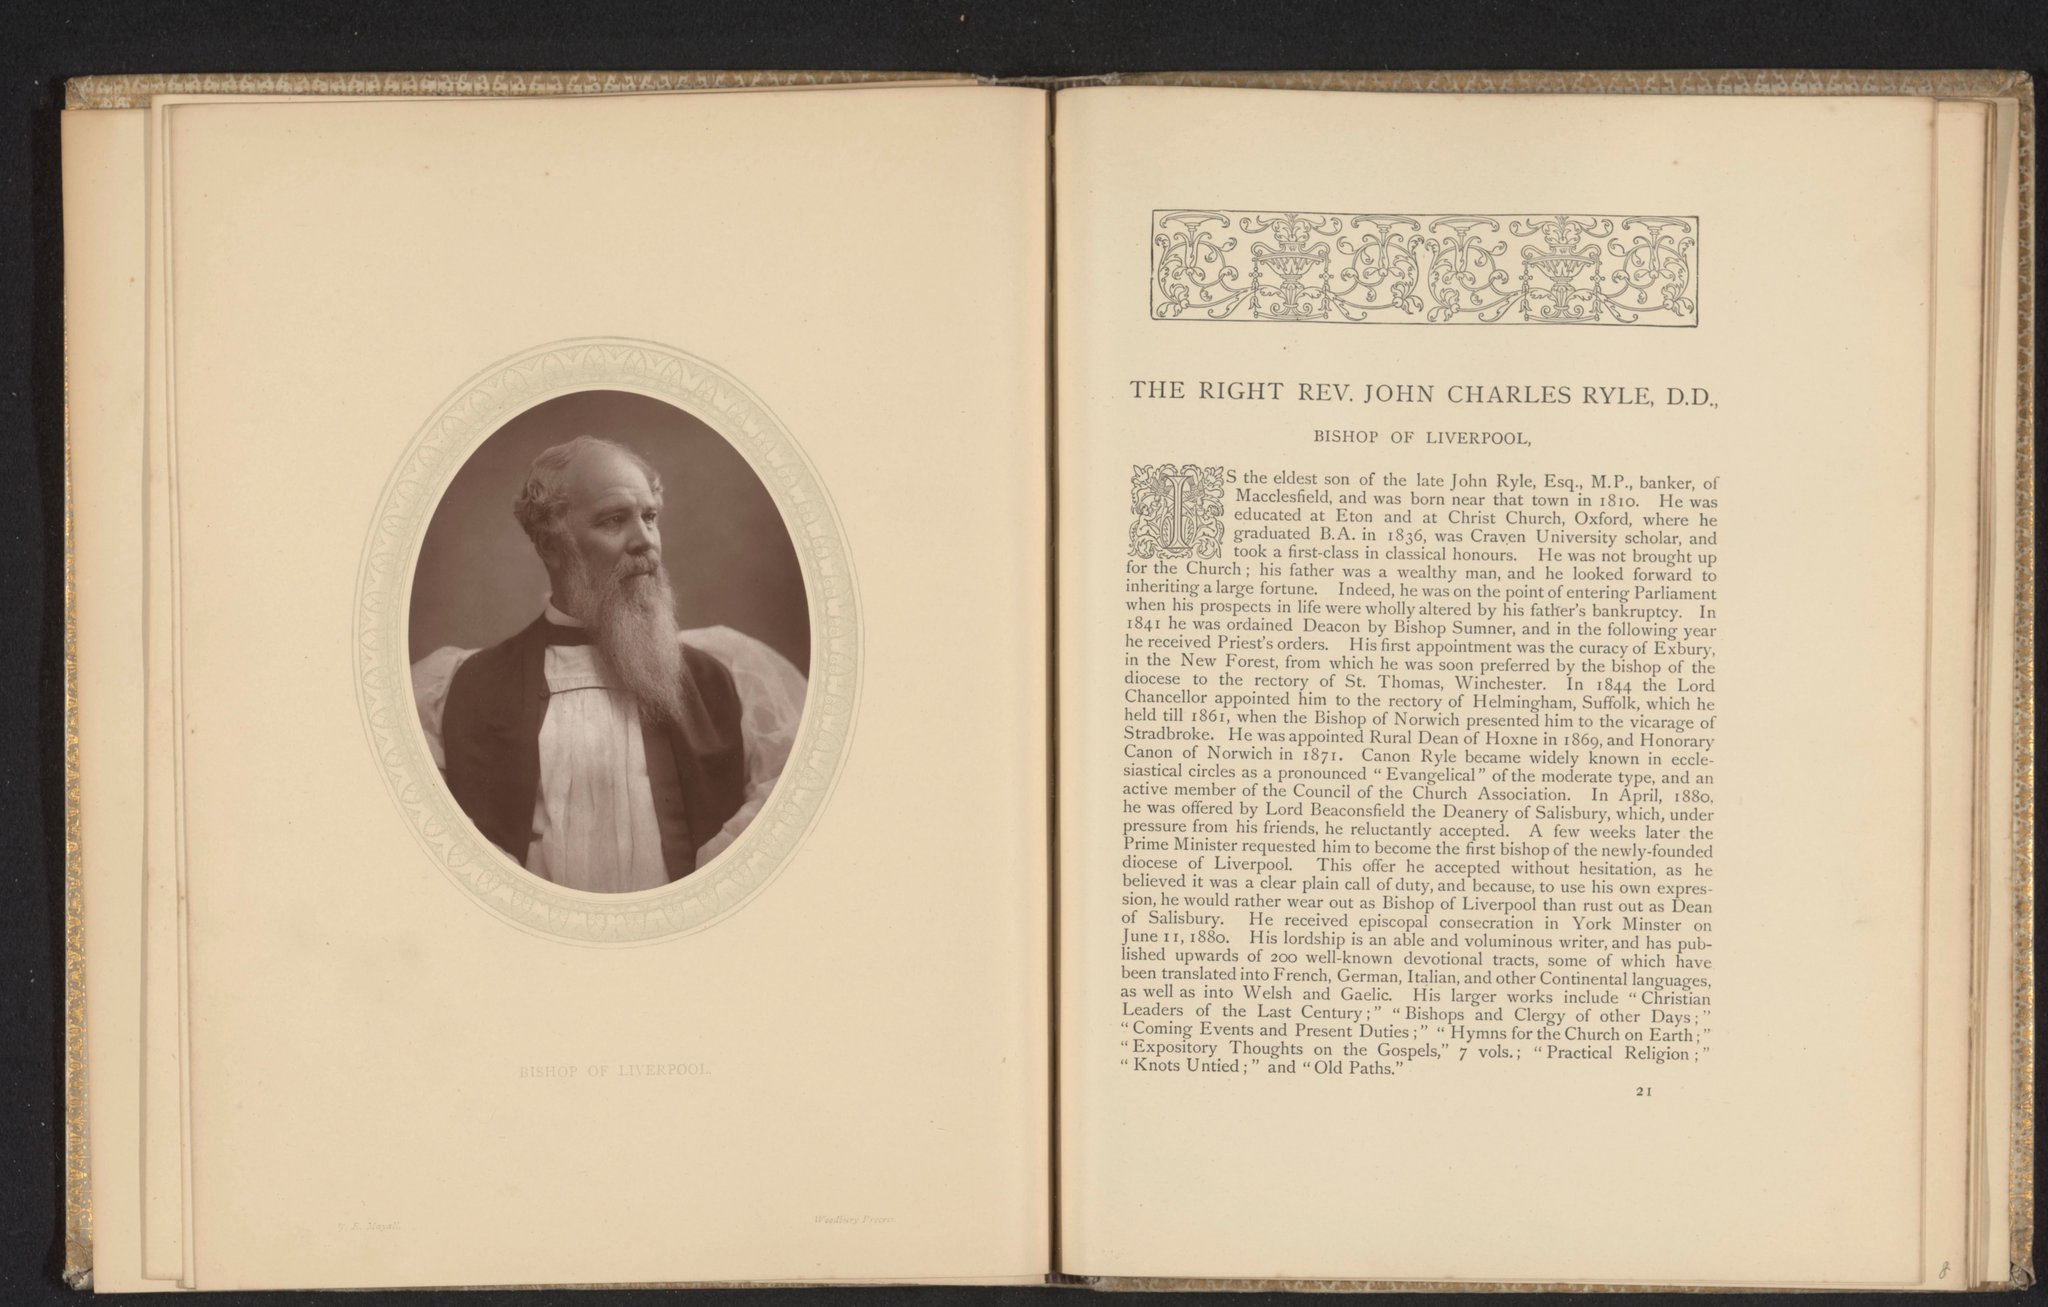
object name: photomechanical print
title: Bishop of Liverpool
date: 1878-1883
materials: paper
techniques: woodburytype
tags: functionaries and dignitaries ~ episcopal protestant churches, historical persons (portraits and scenes from the life) (+ (full) bust portrait)